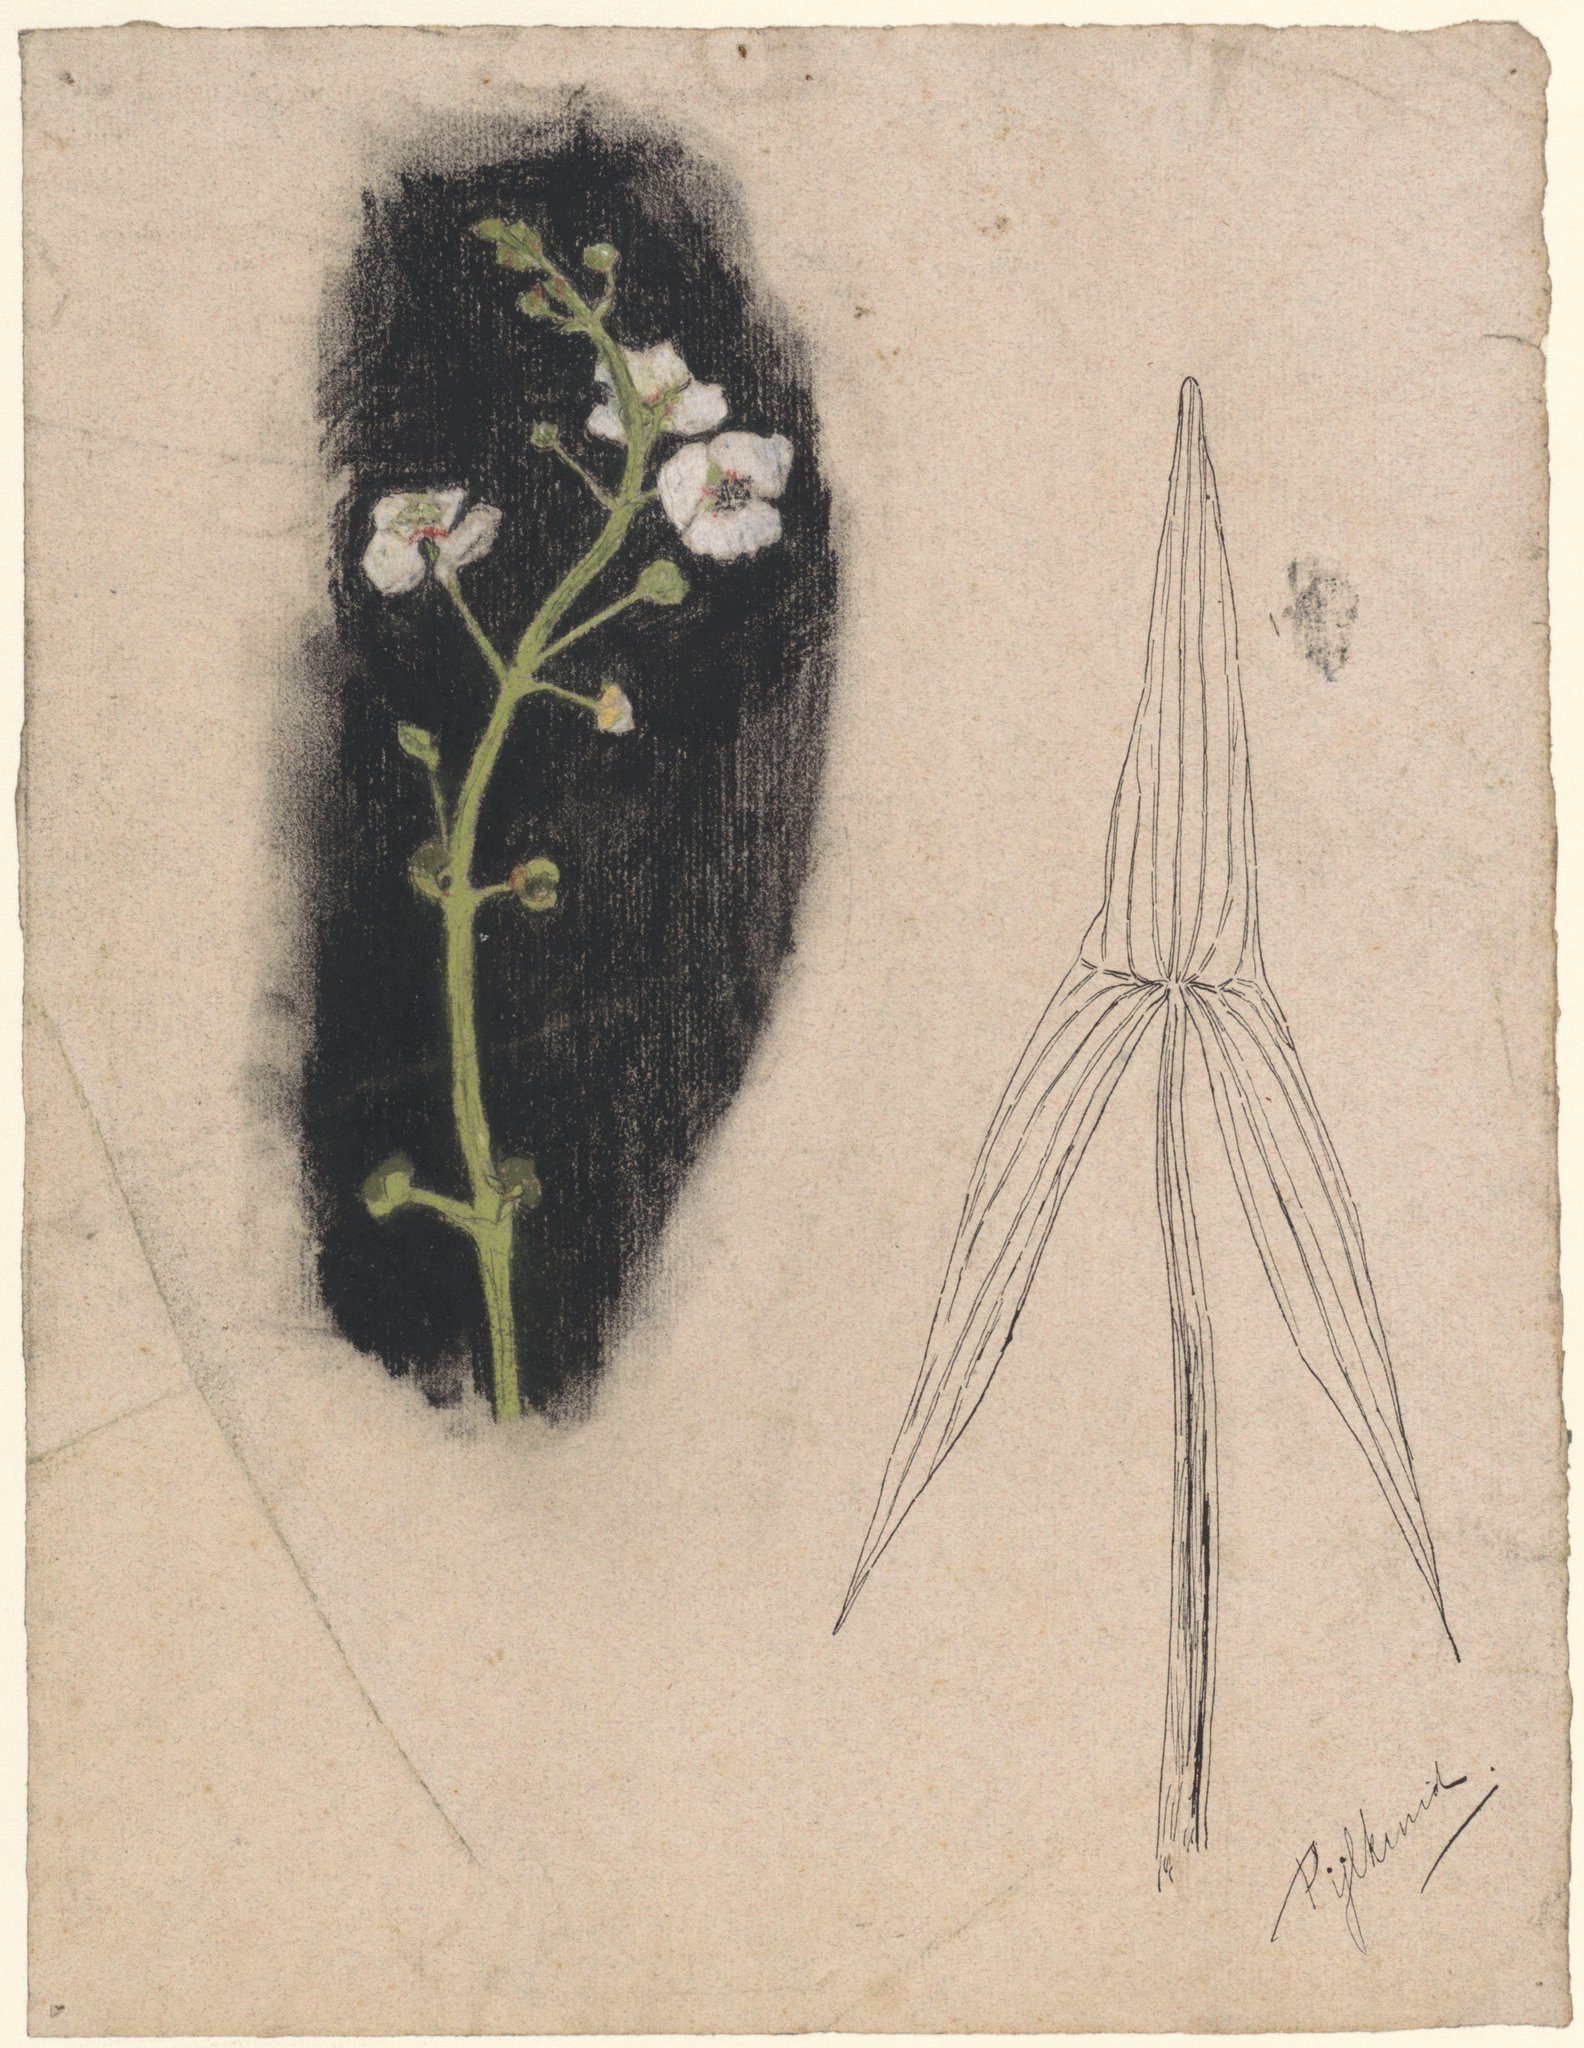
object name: drawing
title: Plantenstudie met pijlkruid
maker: theo nieuwenhuis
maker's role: designer, draughtsman, print maker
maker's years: 1866-1951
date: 1876-1951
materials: chalk, ink, paper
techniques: pen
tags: flowers, plants and herbs: arrowhead